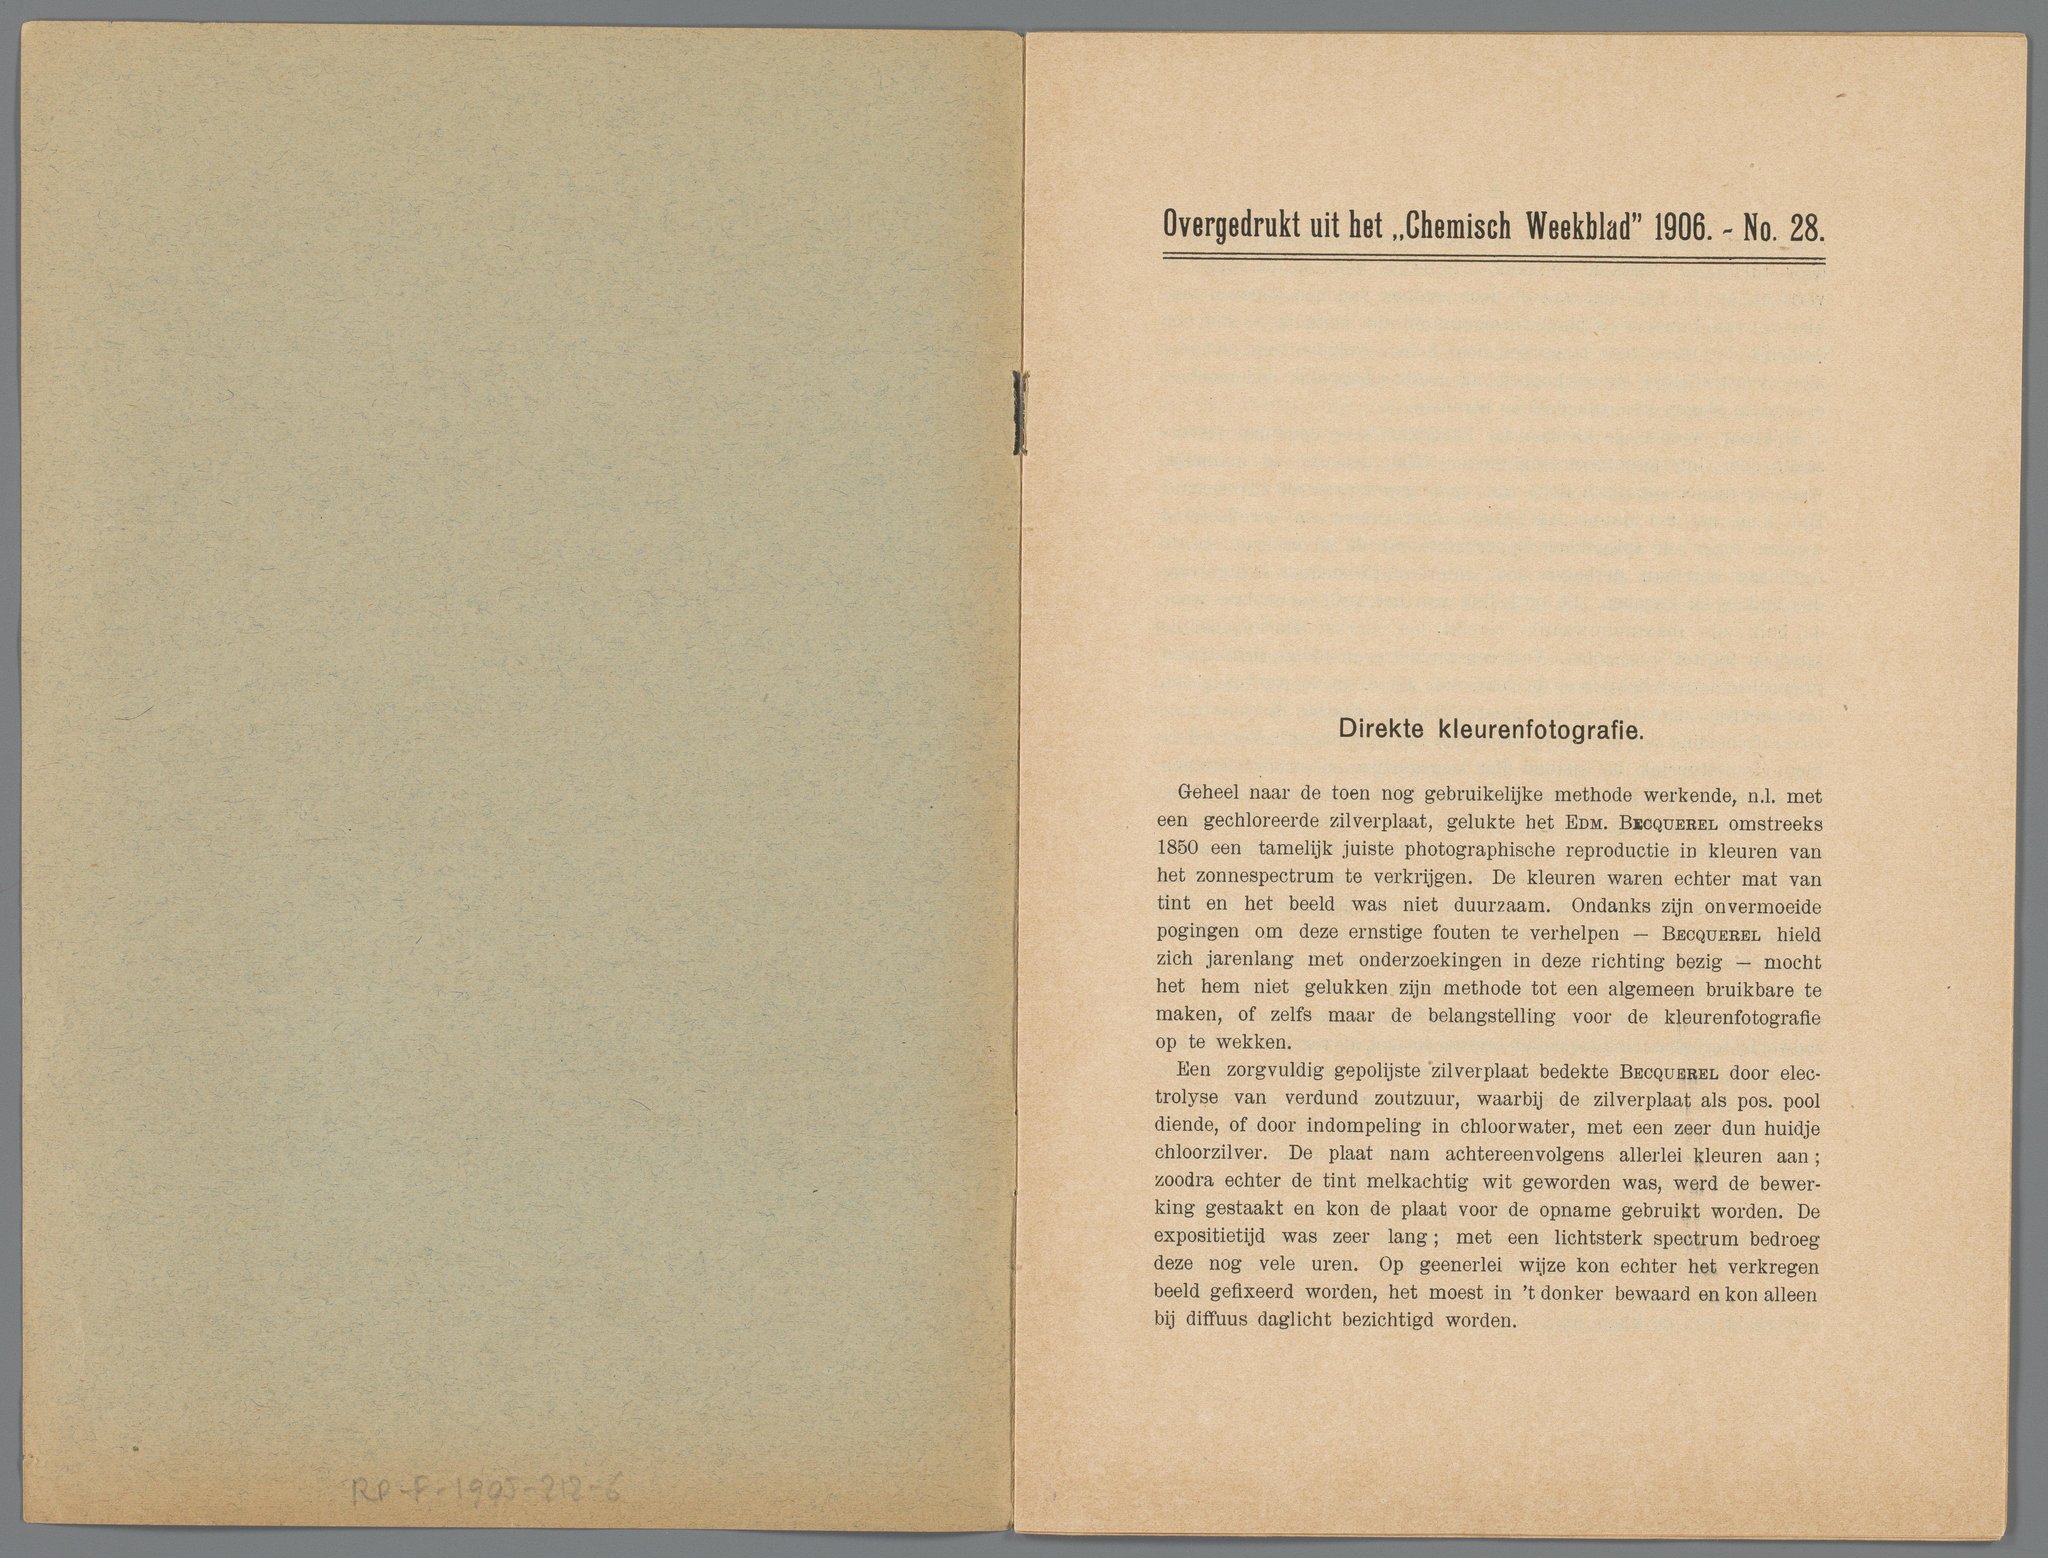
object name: offprint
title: Direkte kleurenfotografie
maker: jacob olie jr.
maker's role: fotograaf, scheikundige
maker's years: 1879-1955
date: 1906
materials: paper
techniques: letterpress printing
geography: amsterdam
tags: printed matter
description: Overdruk uit het Chemisch Weekblad, nummer 28, 1906.